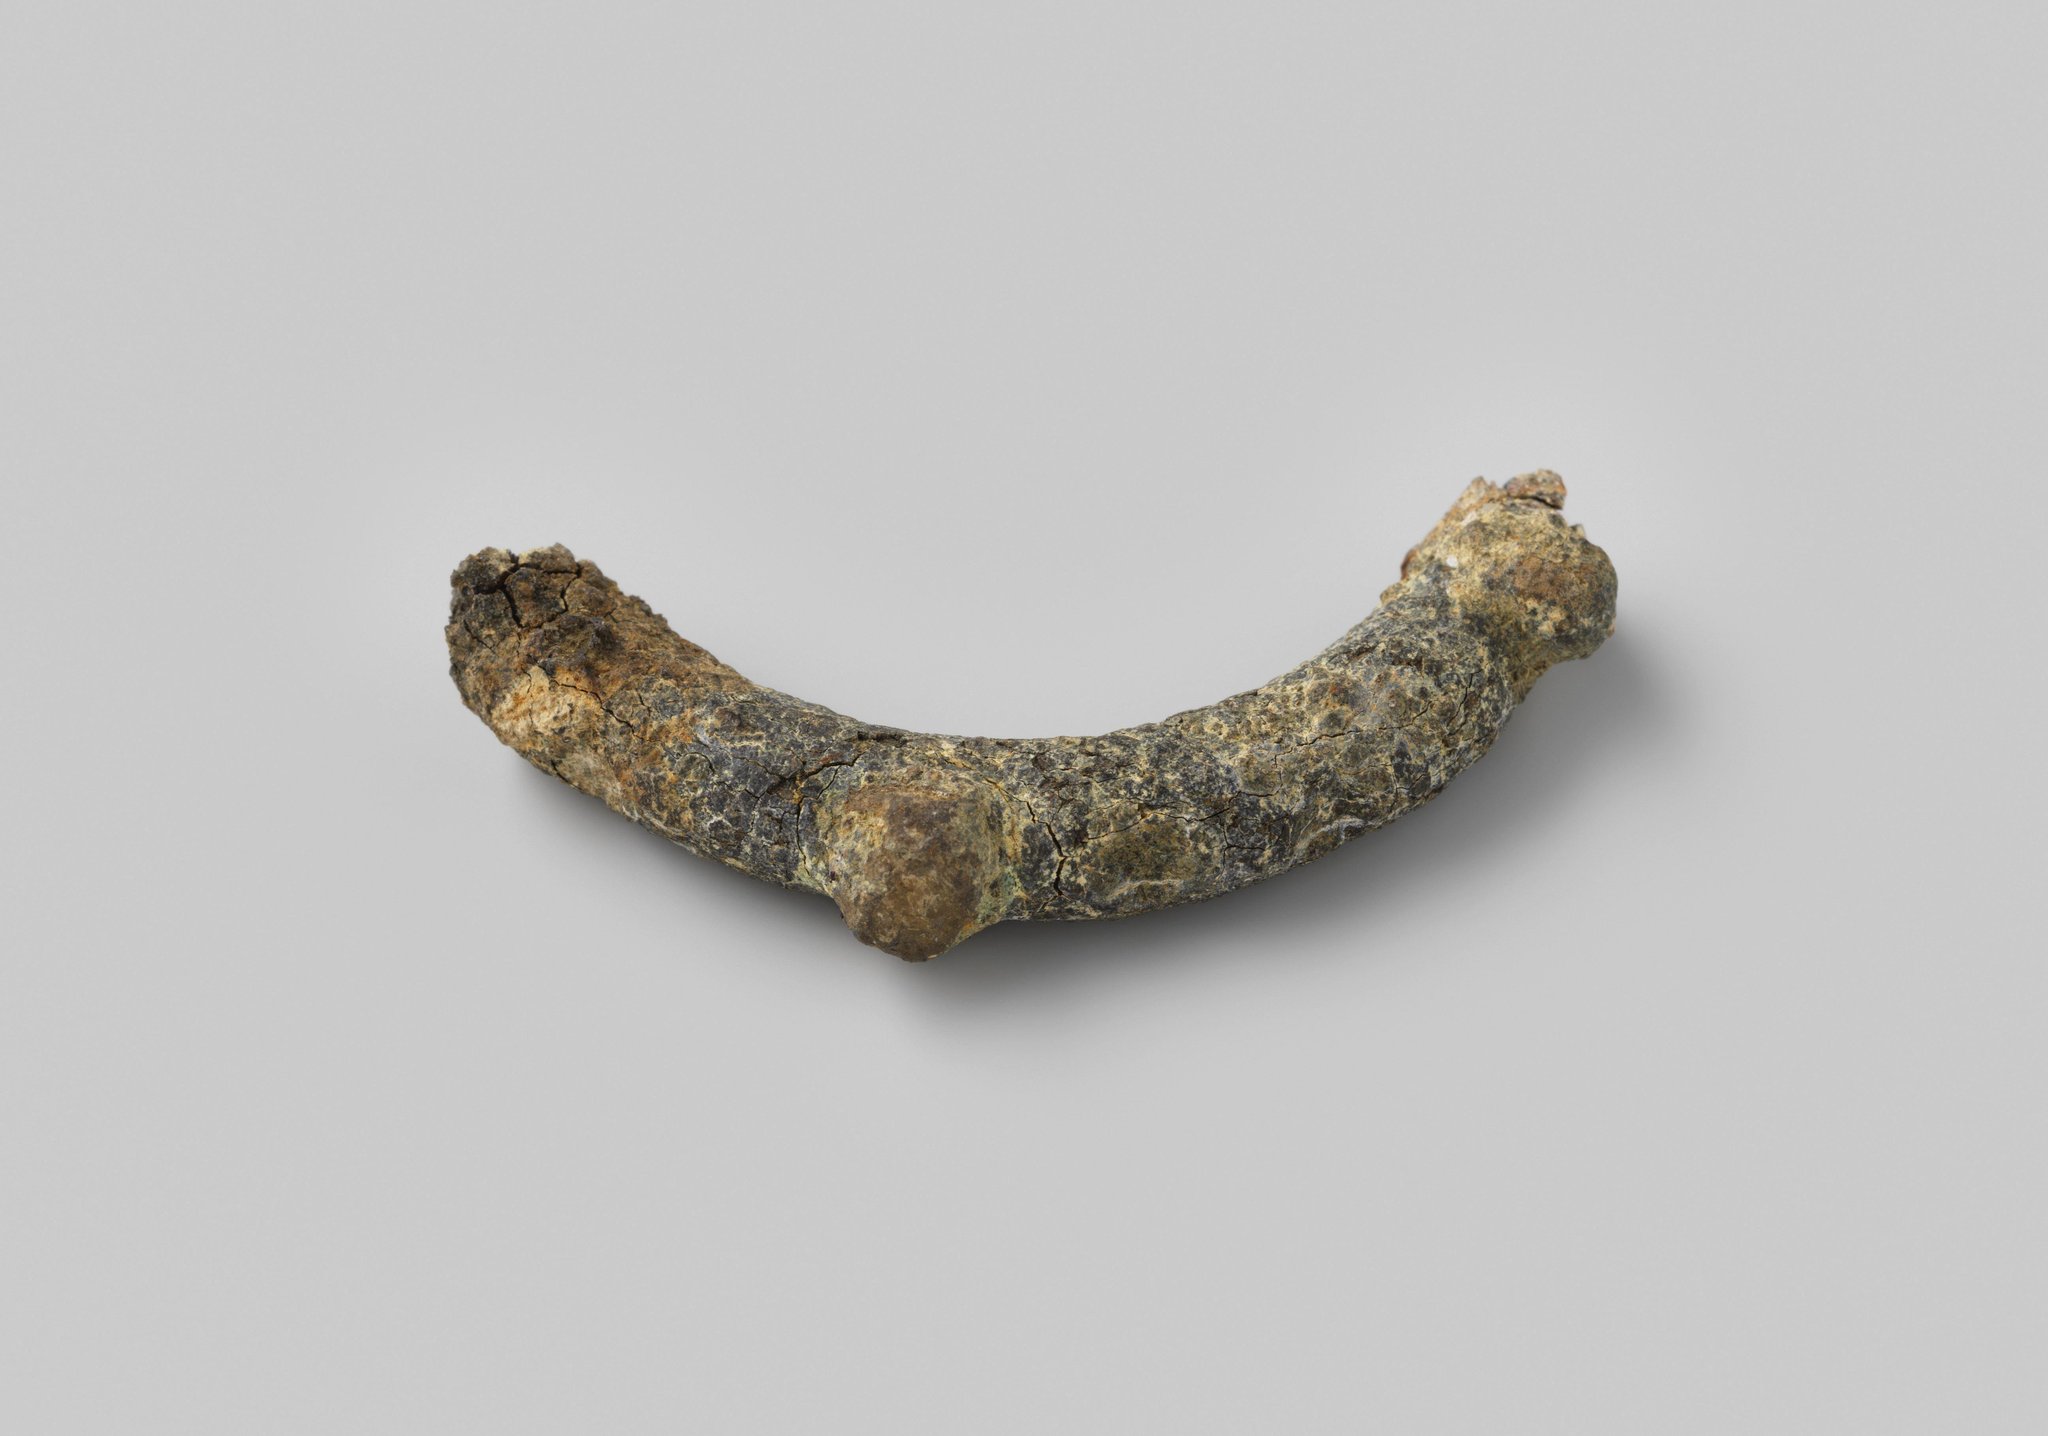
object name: fragment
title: Halve ringvormige fragment uit het wrak van de Oost-Indiëvaarder Hollandia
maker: Anonymous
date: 1700-1743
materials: tin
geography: netherlands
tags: verenigde oostindische compagnie, hollandia (schip), annet